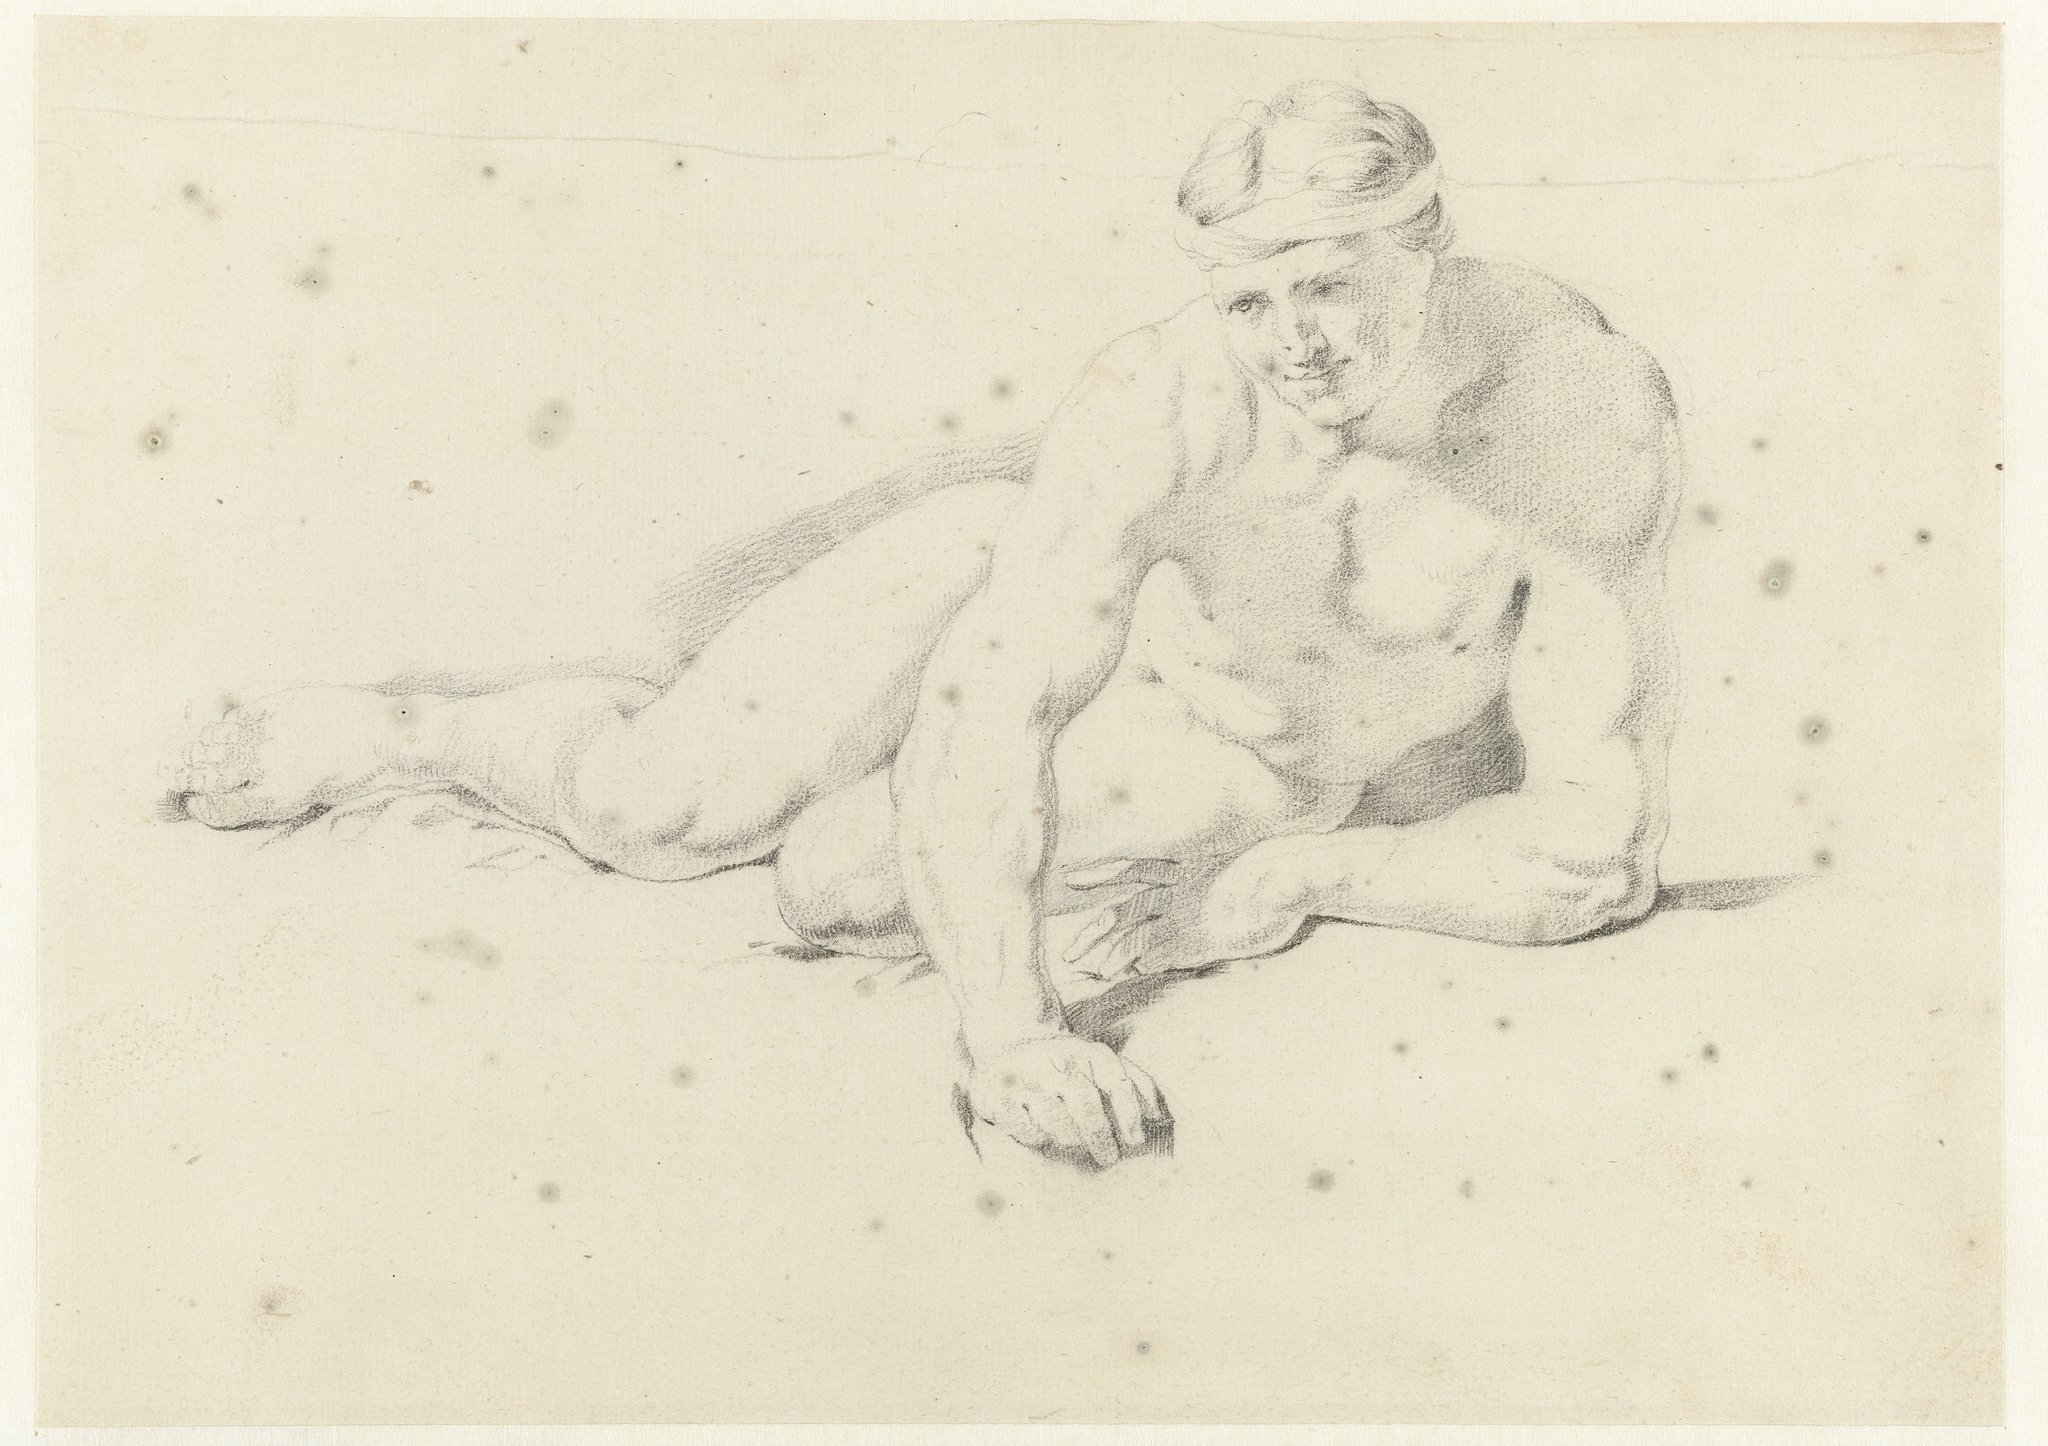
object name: drawing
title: Liggend mannelijk naakt, naar rechts en steunend op de armen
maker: jan hoogsaat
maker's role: painter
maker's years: 1654-1750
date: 1664-1730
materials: chalk, paper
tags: lying on one side, with uplifted upper part of the body and leaning on the arm, human figure of ideal proportions, e.g. academic nude